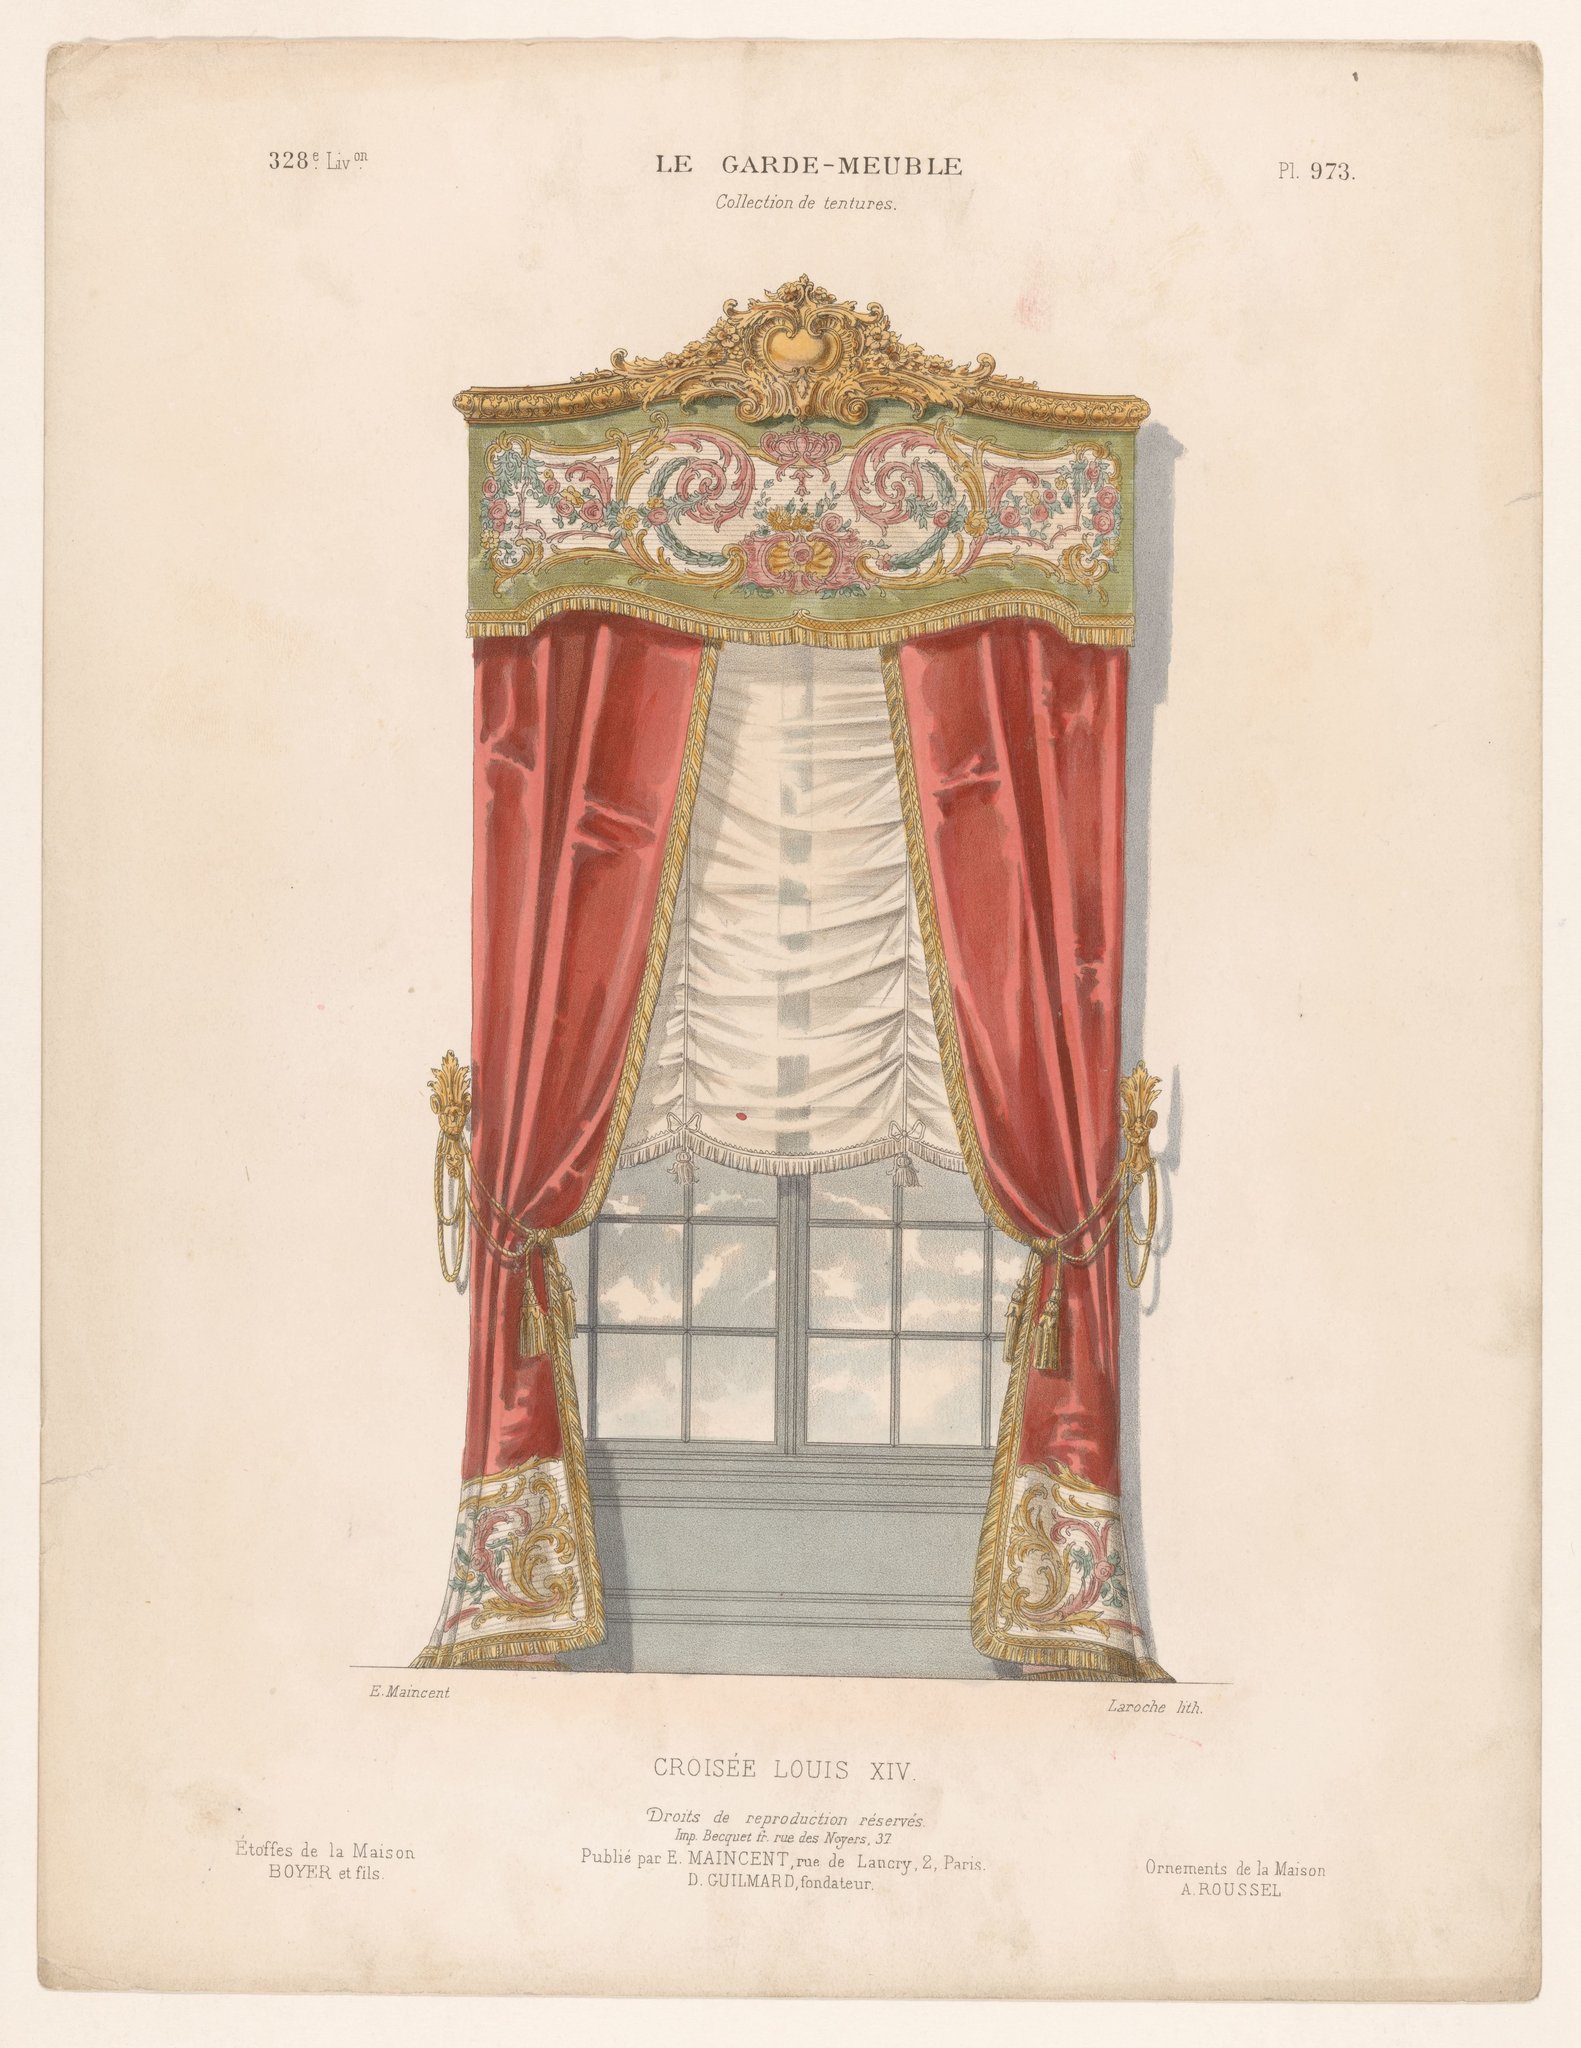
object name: print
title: Le Garde-Meuble / Collection de Tentures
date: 1885-1895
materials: paper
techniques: hand coloring, lithograph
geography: paris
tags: window, hangings and drapery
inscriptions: : ‘Droits de reproduction réservés.’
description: Kruisvenster met gedrapeerde gordijnen in de Lodewijk XIV-stijl. Prent uit 328e Livraison.